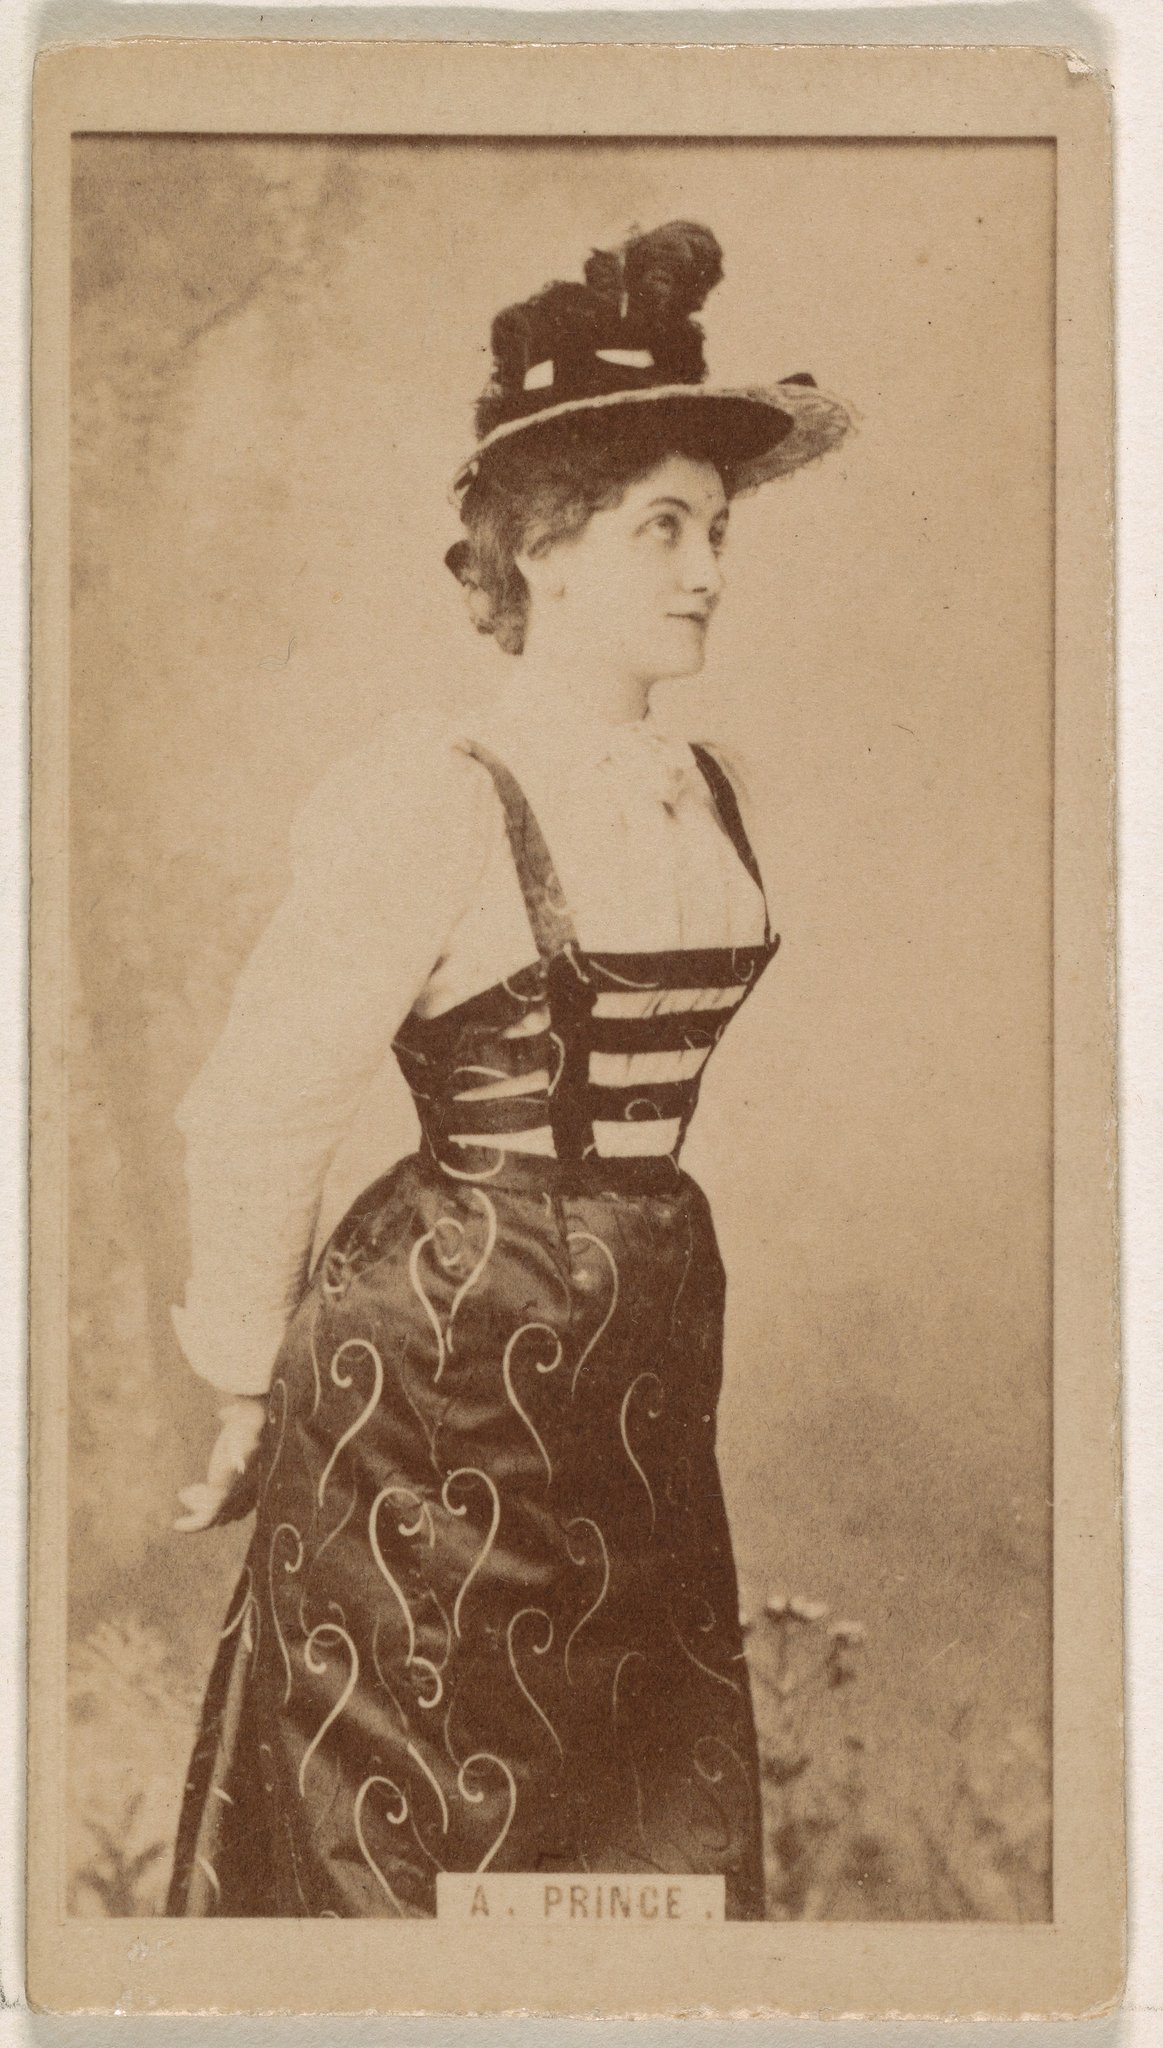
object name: photograph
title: Adelaide Prince, from the Actresses series (N245) issued by Kinney Brothers to promote Sweet Caporal Cigarettes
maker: kinney brothers tobacco company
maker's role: publisher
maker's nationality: american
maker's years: 1869-2011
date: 1890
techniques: albumen silver print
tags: women,actresses